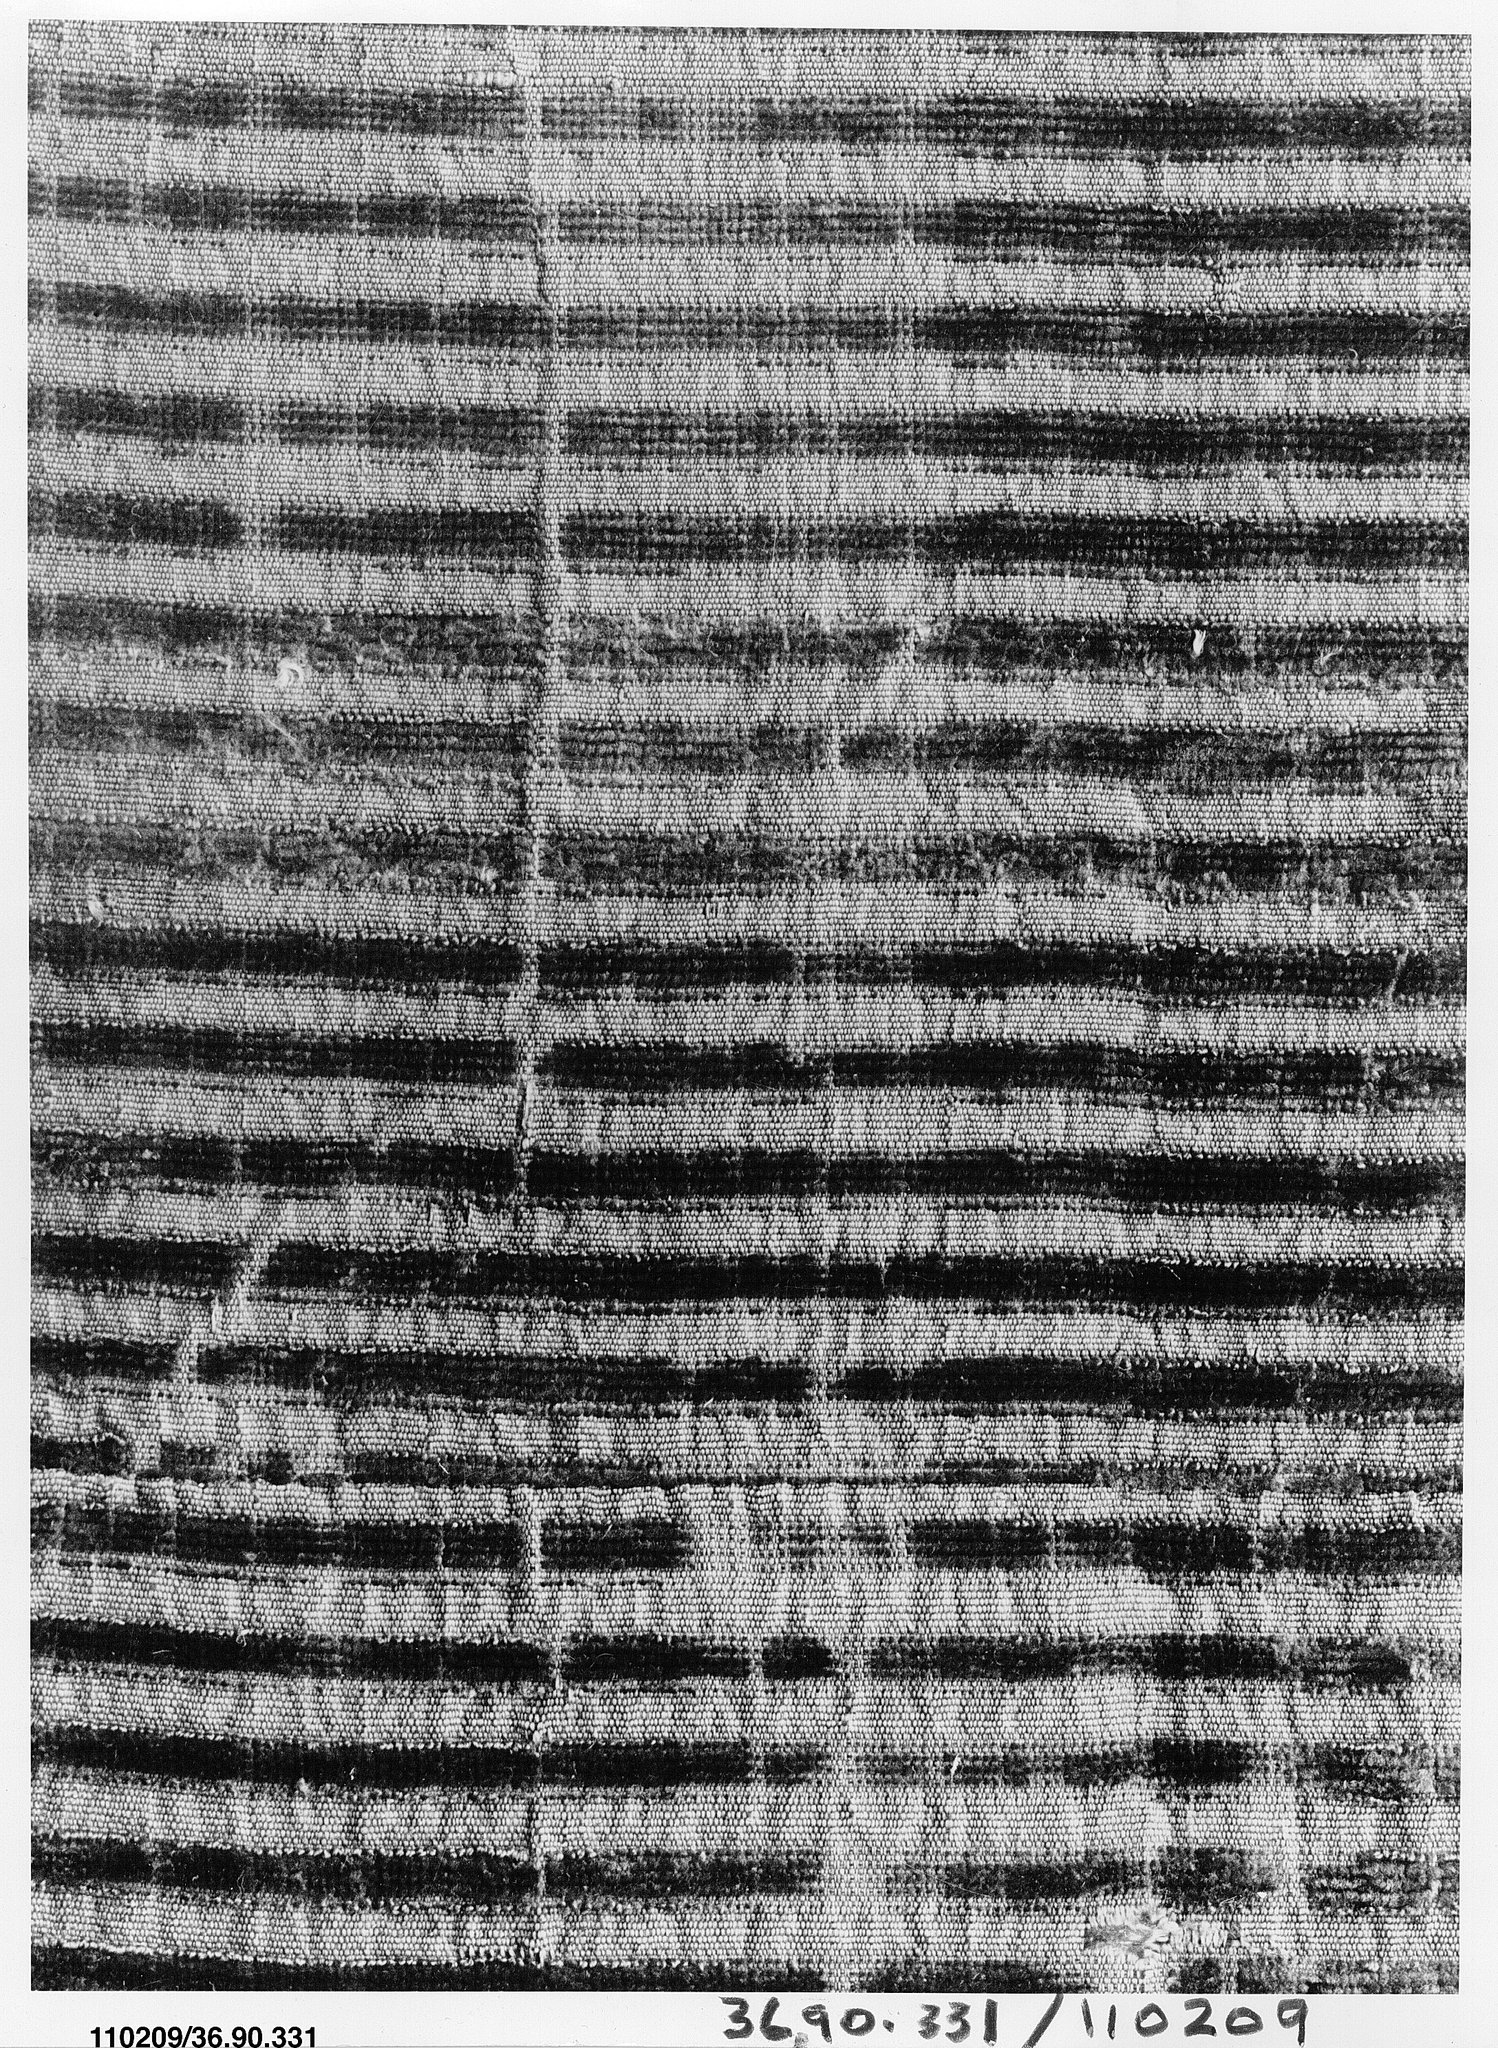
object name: piece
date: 1501-1700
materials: metal thread, silk